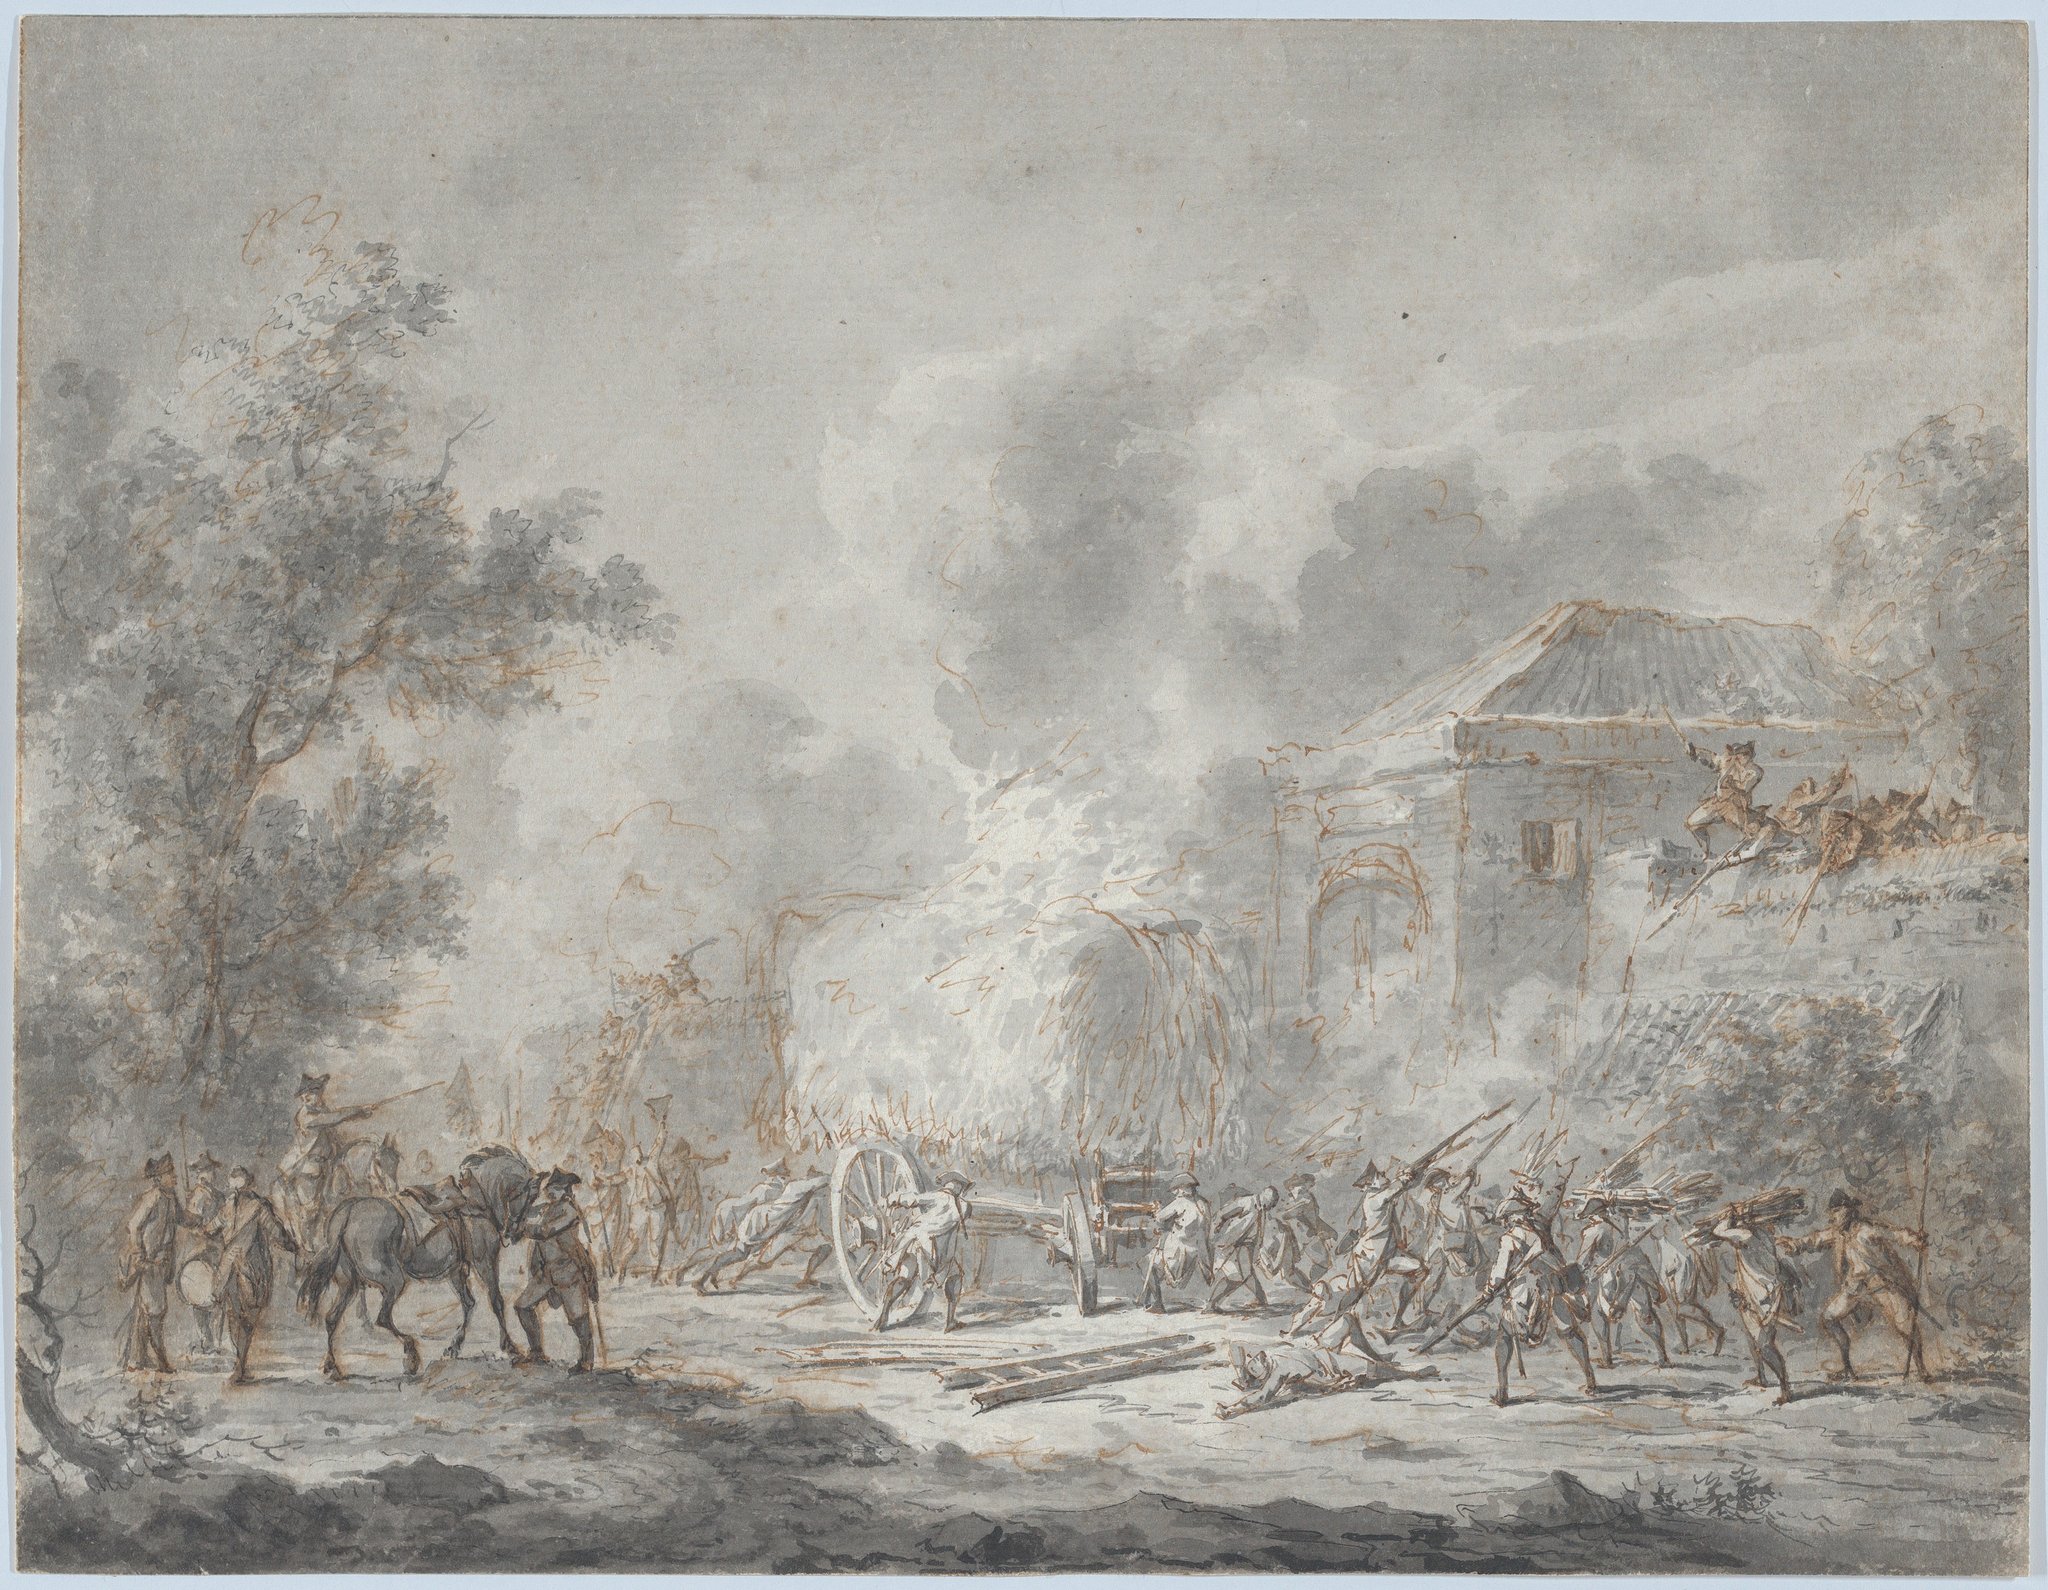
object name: drawing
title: A Skirmish with Soldiers Near a Farm (recto); Sketch with Soldiers (verso)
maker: dirk langendijk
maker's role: artist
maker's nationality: dutch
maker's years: 1748-1805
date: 1790-1800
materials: ink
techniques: brush, pen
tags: battles,soldiers,weapons